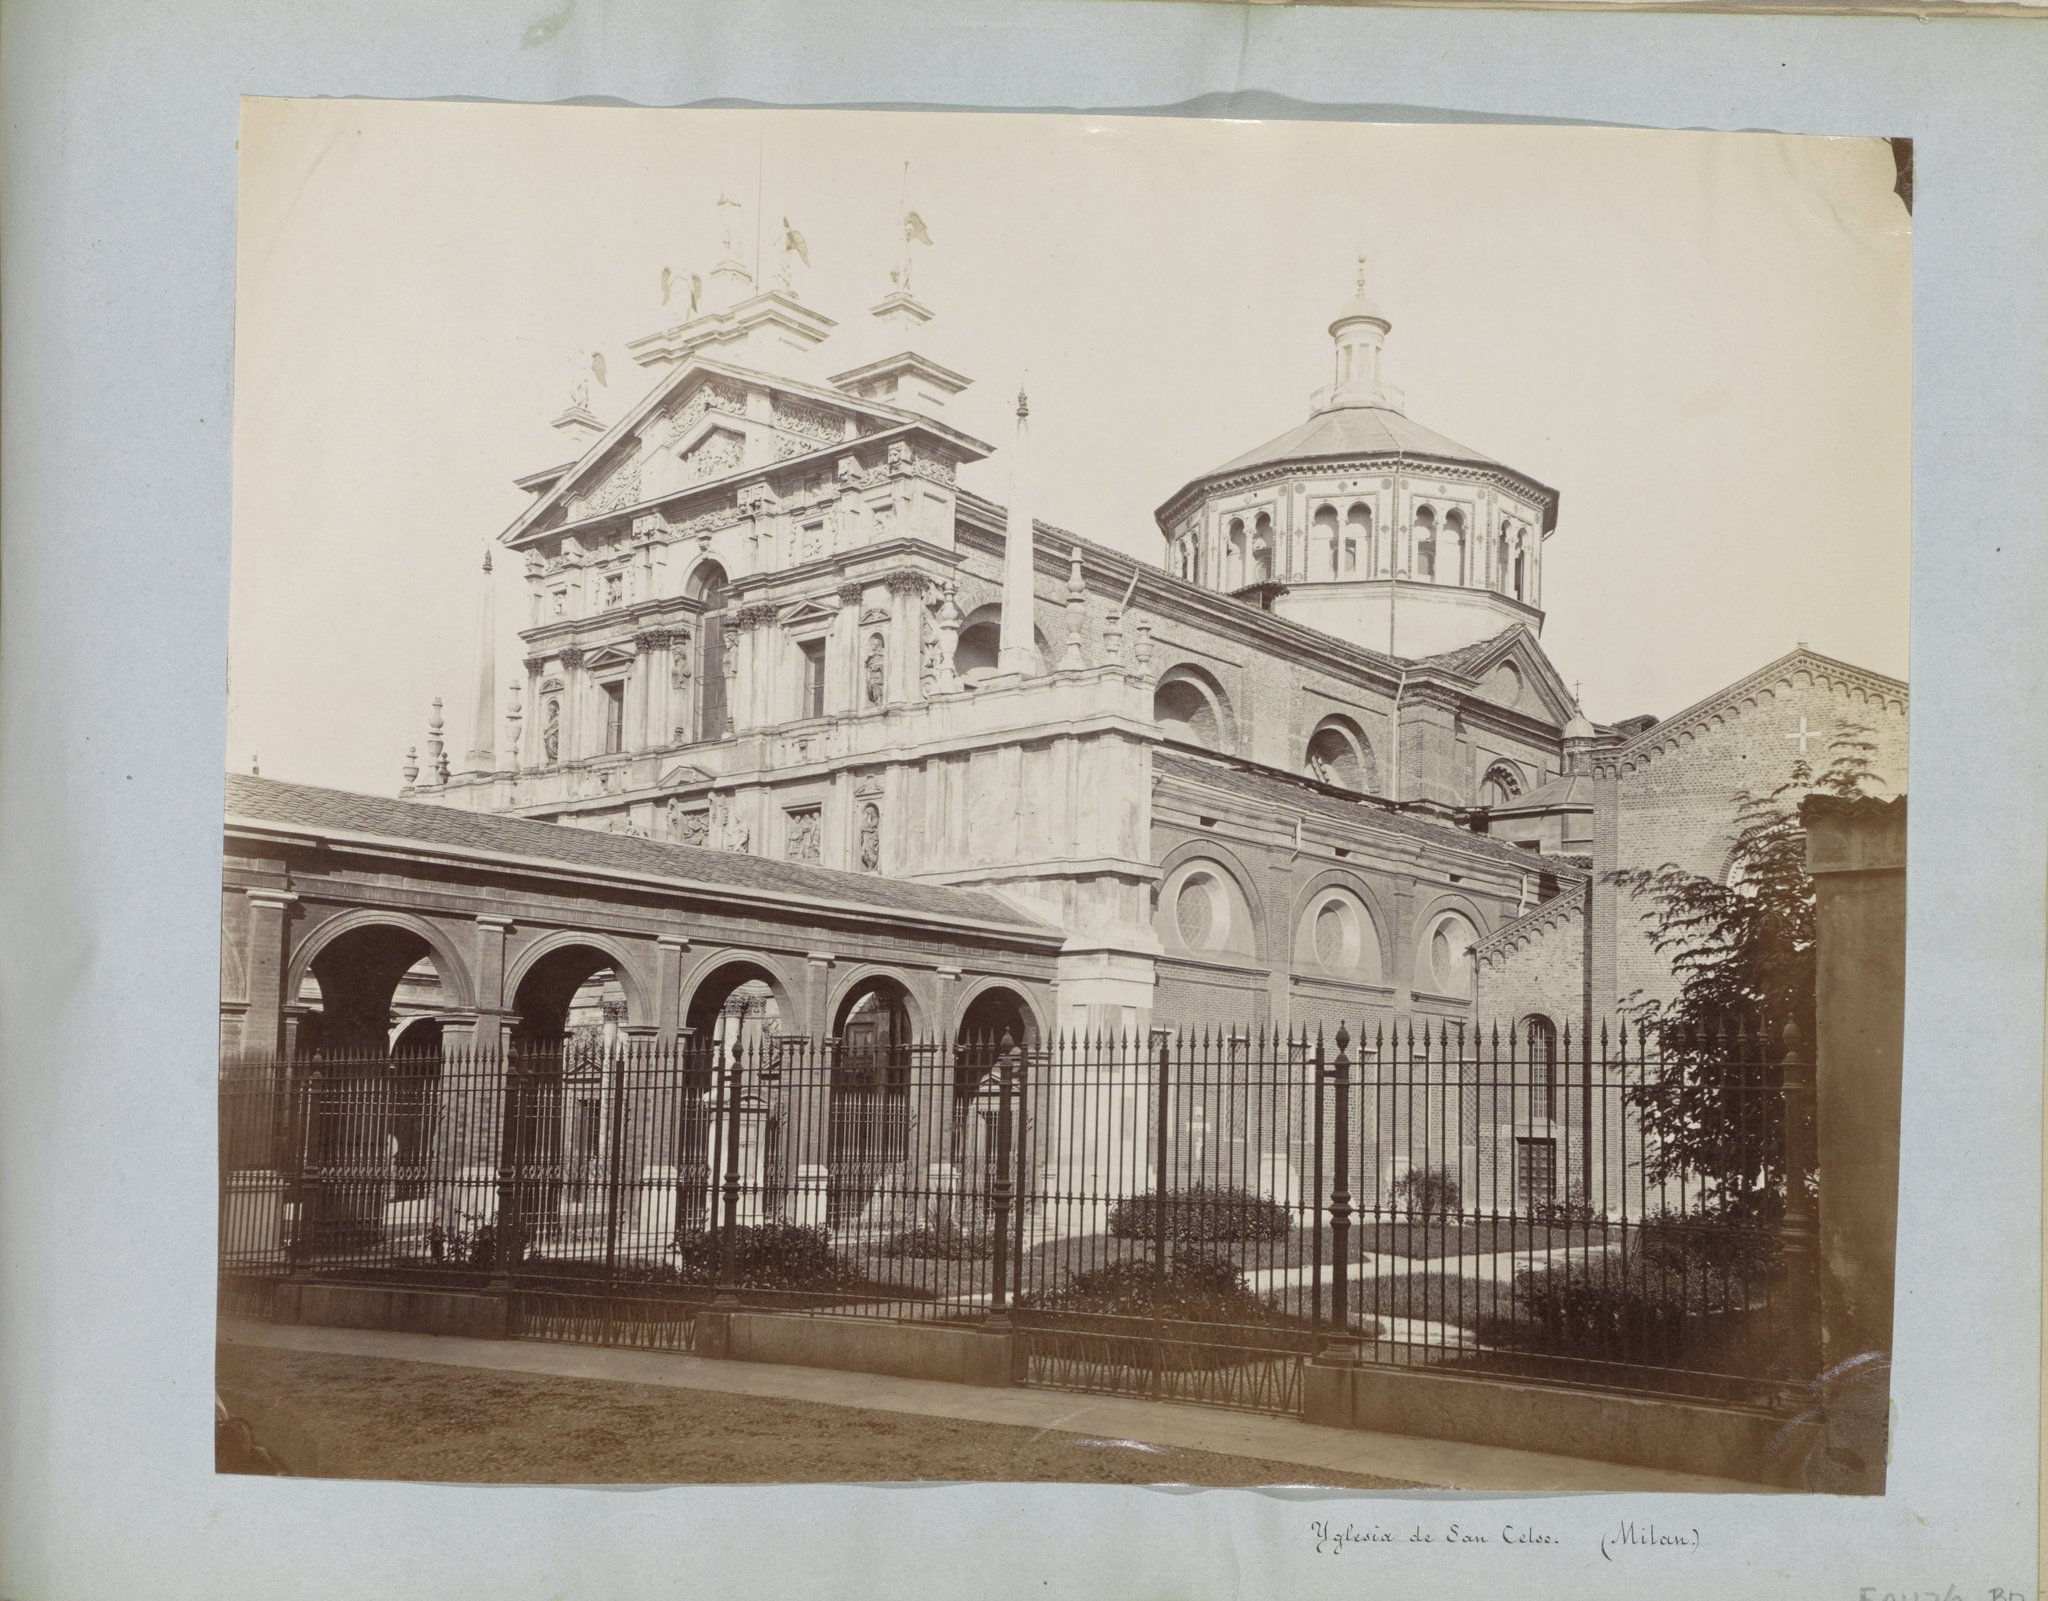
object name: photograph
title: Yglesia de San Celso. (Milan.)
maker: Anonymous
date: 1850-1876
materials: photographic support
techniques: albumen print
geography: milan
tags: roman catholic church (+ mary), travelling; tourism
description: Onderdeel van Reisalbum met foto's en tekeningen van Manuel Mayo 1876.